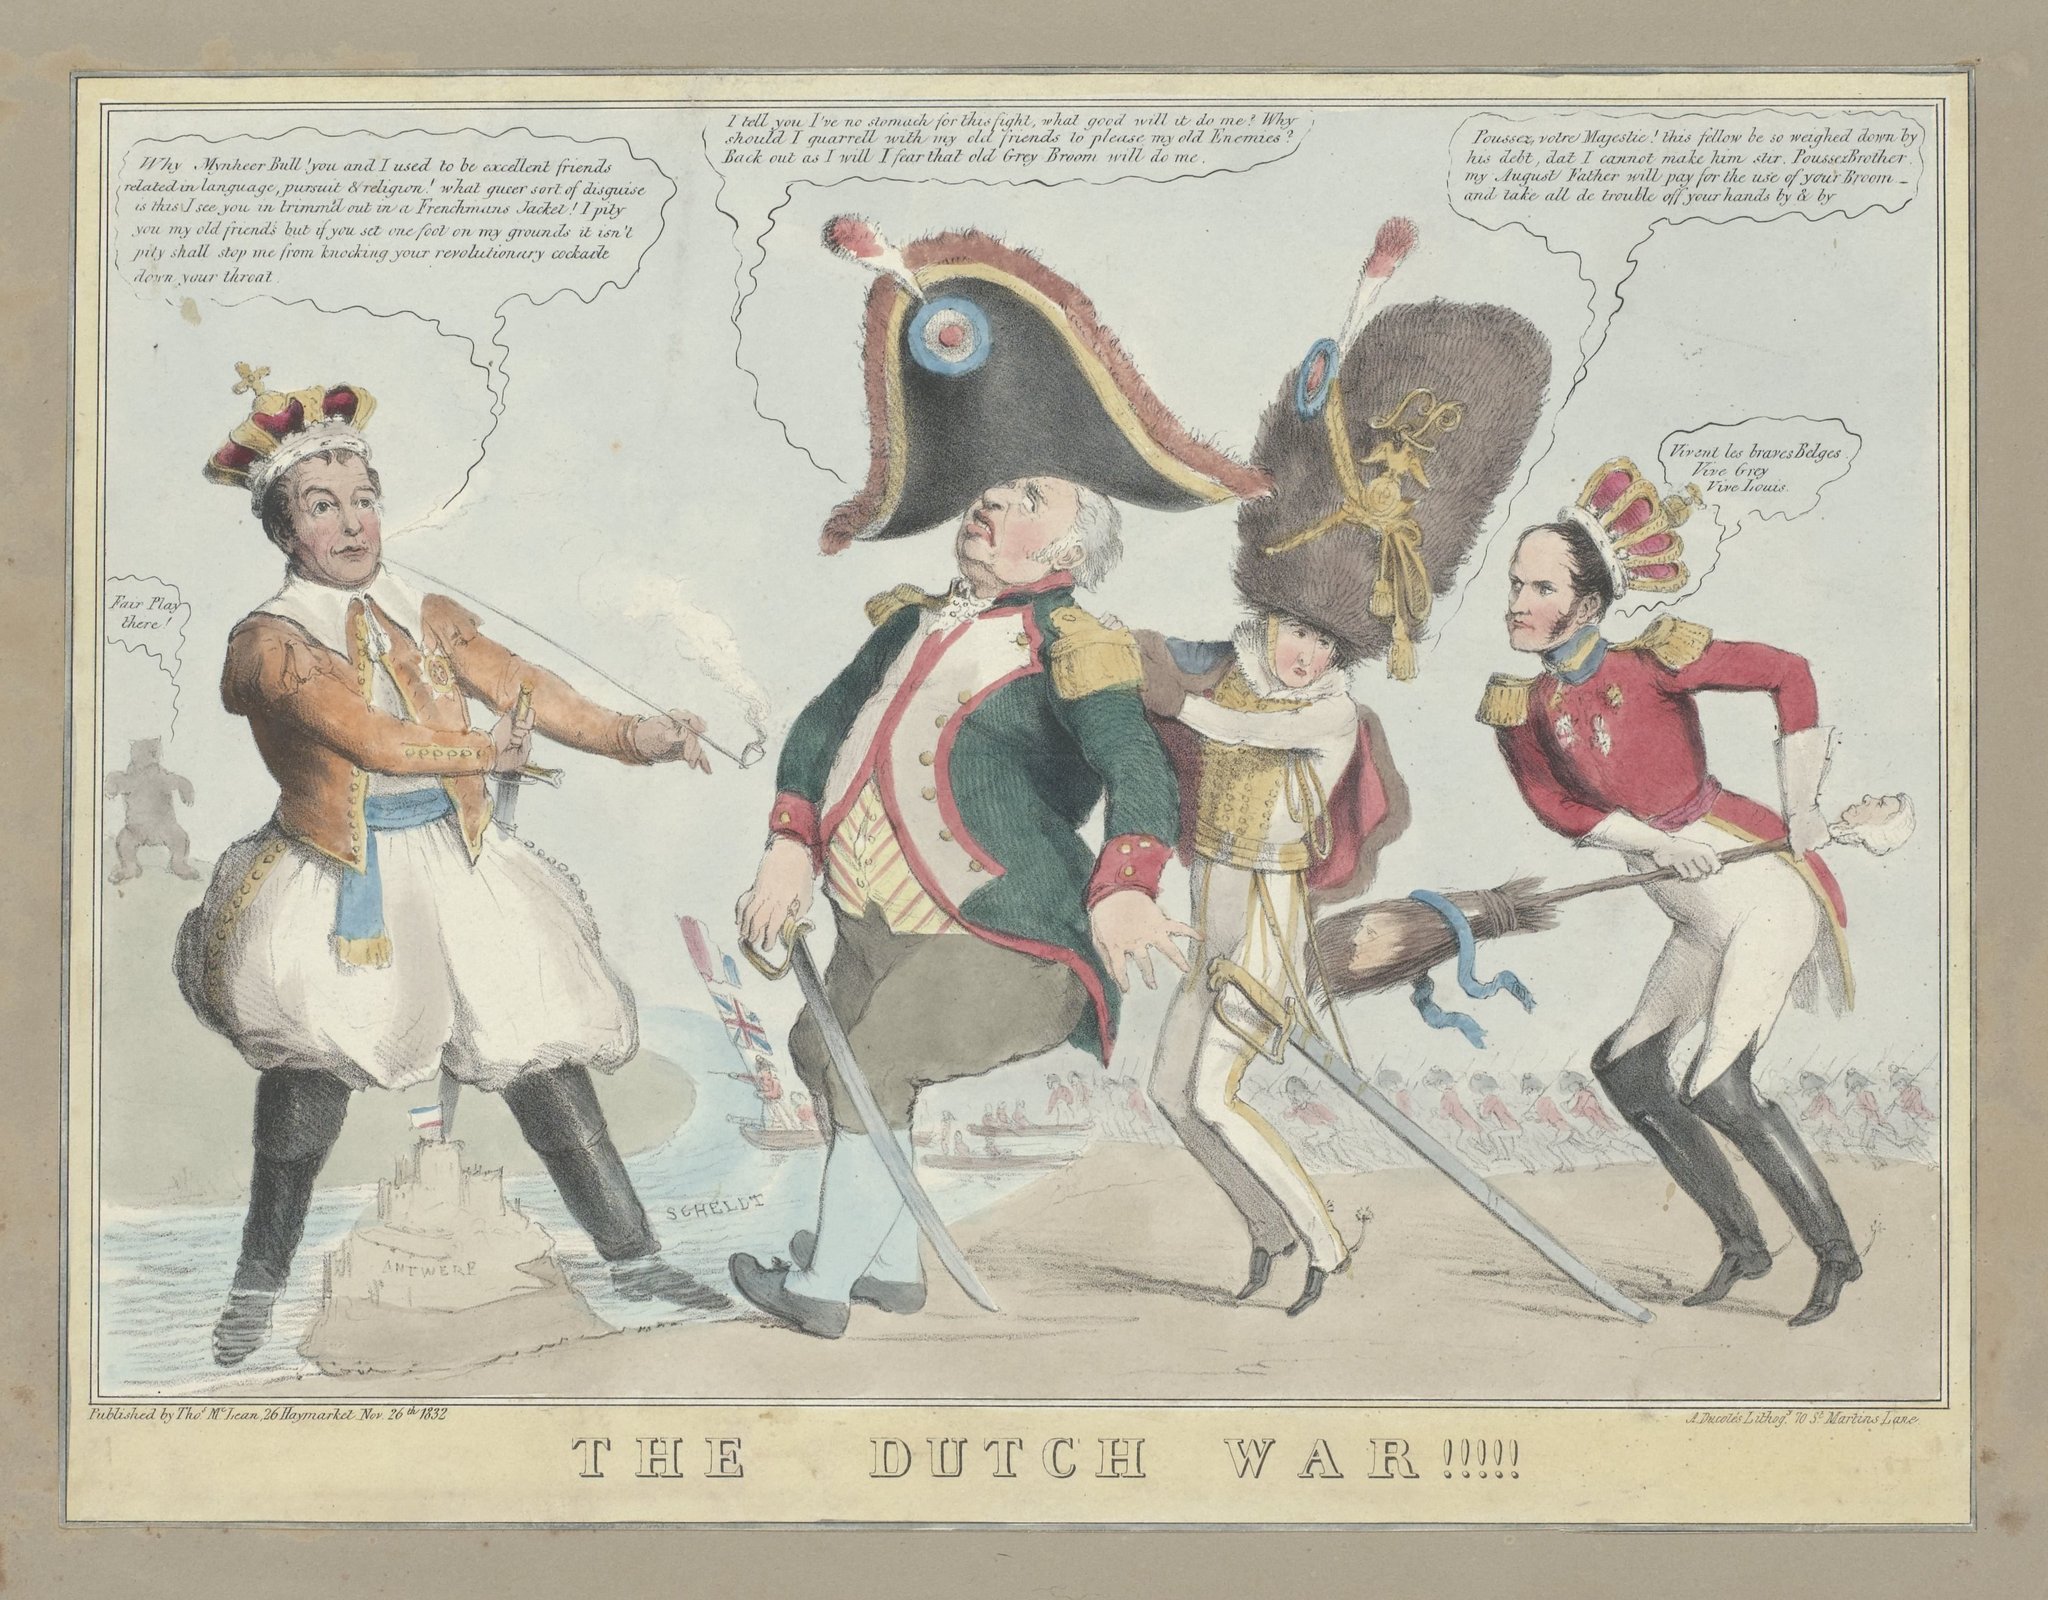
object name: print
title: The Dutch War !!!!!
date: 1832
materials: paper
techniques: hand coloring, lithograph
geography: london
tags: the hague, berlin, william i of the netherlands, laeken, leopold i (koning der belgen), lodewijk filips i (koning van frankrijk), personifications of countries, nations, states, districts, etc., (building) sand-castle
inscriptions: collector's mark: Lugt 2228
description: Spotprent op John Bull (Groot-Brittannië) en de rol die hij wordt gedwongen te spelen in de uitvoering van de XXIV artikelen waarin de onafhankelijkheid van België door Groot-Brittannië en Frankrijk wordt gewaarborgd. De Belgische koning Leopold jaagt met een bezem (waarin het profiel van premier Grey) de Britse (John Bull) en Franse (hertog van Orléans) vertegenwoordigers op tegen de Nederlandse koning Willem I. Willem heeft een zandkasteel aangeduid als Antwerpen aan de oever van de Schelde gebouwd. Op de achtergrond trekken de Franse en Britse troepen gezamenlijk over de Schelde, links in de verte de Russische beer.